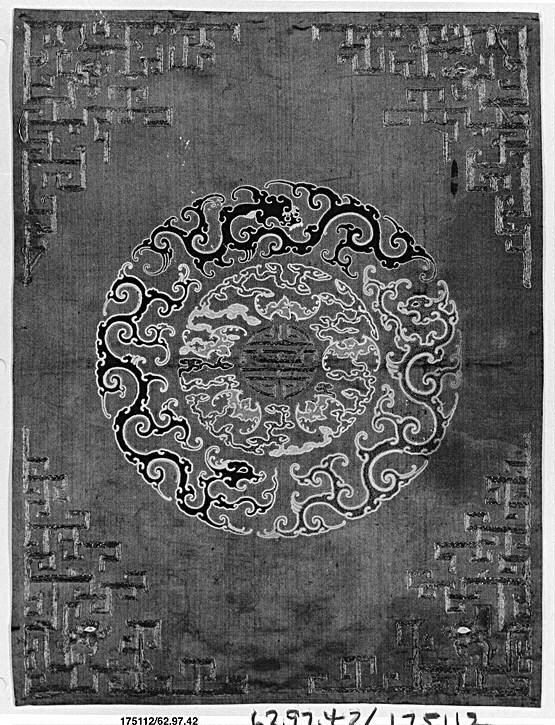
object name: furniture cover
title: Furniture Cover for Chair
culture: chinese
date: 1662-1722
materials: linen, metal thread, silk